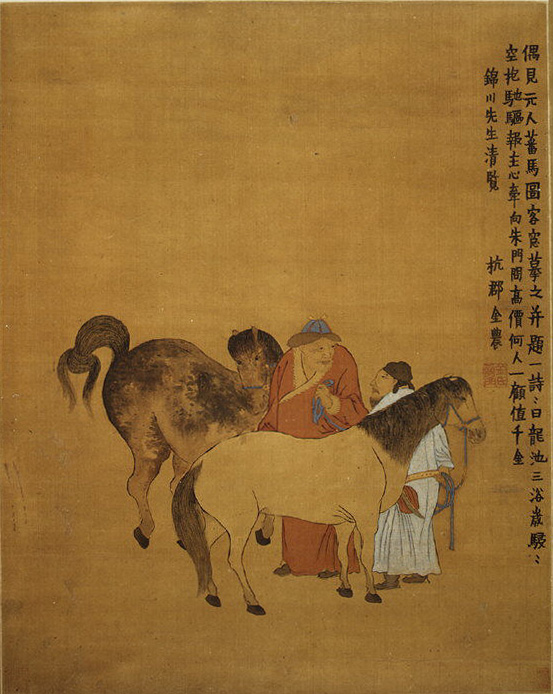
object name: hanging scroll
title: Grooms and Foreign Horses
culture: chinese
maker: jin nong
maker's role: artist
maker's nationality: chinese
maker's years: 1687-1773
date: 1601-1800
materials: ink, silk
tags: men,horses